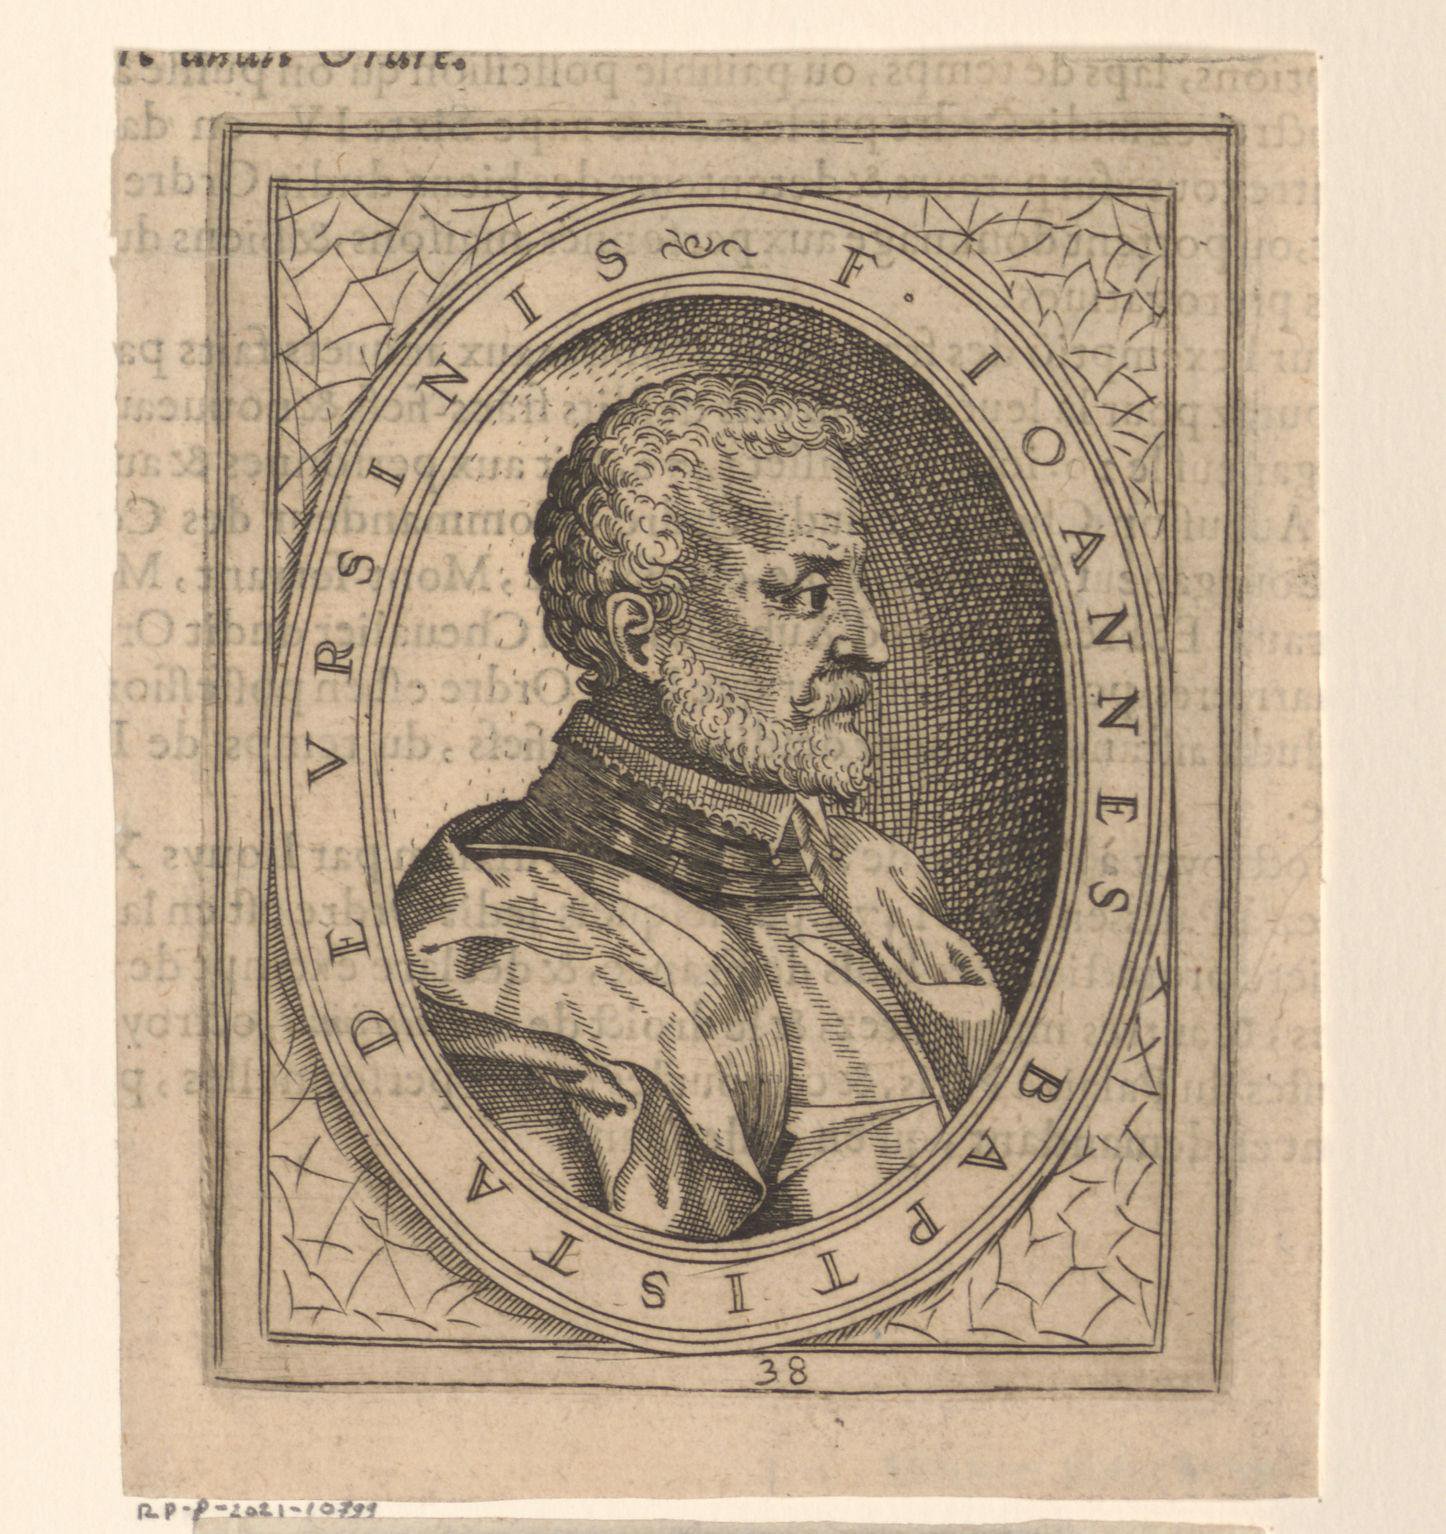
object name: print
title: Portret van Giovanni Battista Orsini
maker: Anonymous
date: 1643-1659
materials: paper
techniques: engraving, letterpress printing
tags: historical persons, military orders, e.g.: knights templars, knights of malta, teutonic knights ~ roman catholic church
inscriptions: collector's mark: Lugt 2228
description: Prent mogelijk uit: Baudoin, Jean. Histoire des chevaliers de l'ordre de s. Jean de Hierusalem (...). Parijs: Jacques Dallin, 1643. Of uit: Baudoin, Jean. Histoire des chevaliers de l'ordre de s. Jean de Hierusalem (...). Parijs: Thomas Jolly, 1659.